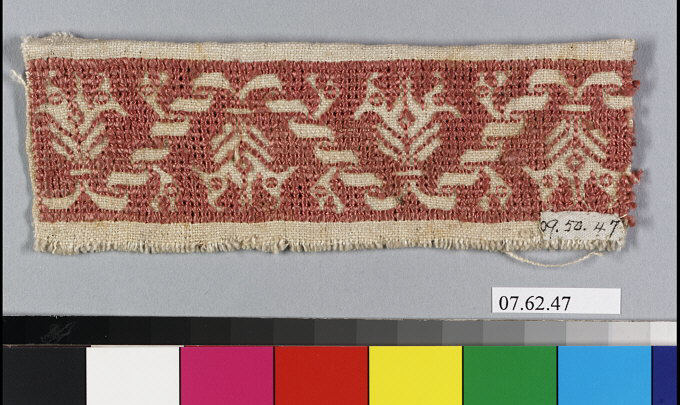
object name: strip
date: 1501-1700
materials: linen, silk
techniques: embroidery